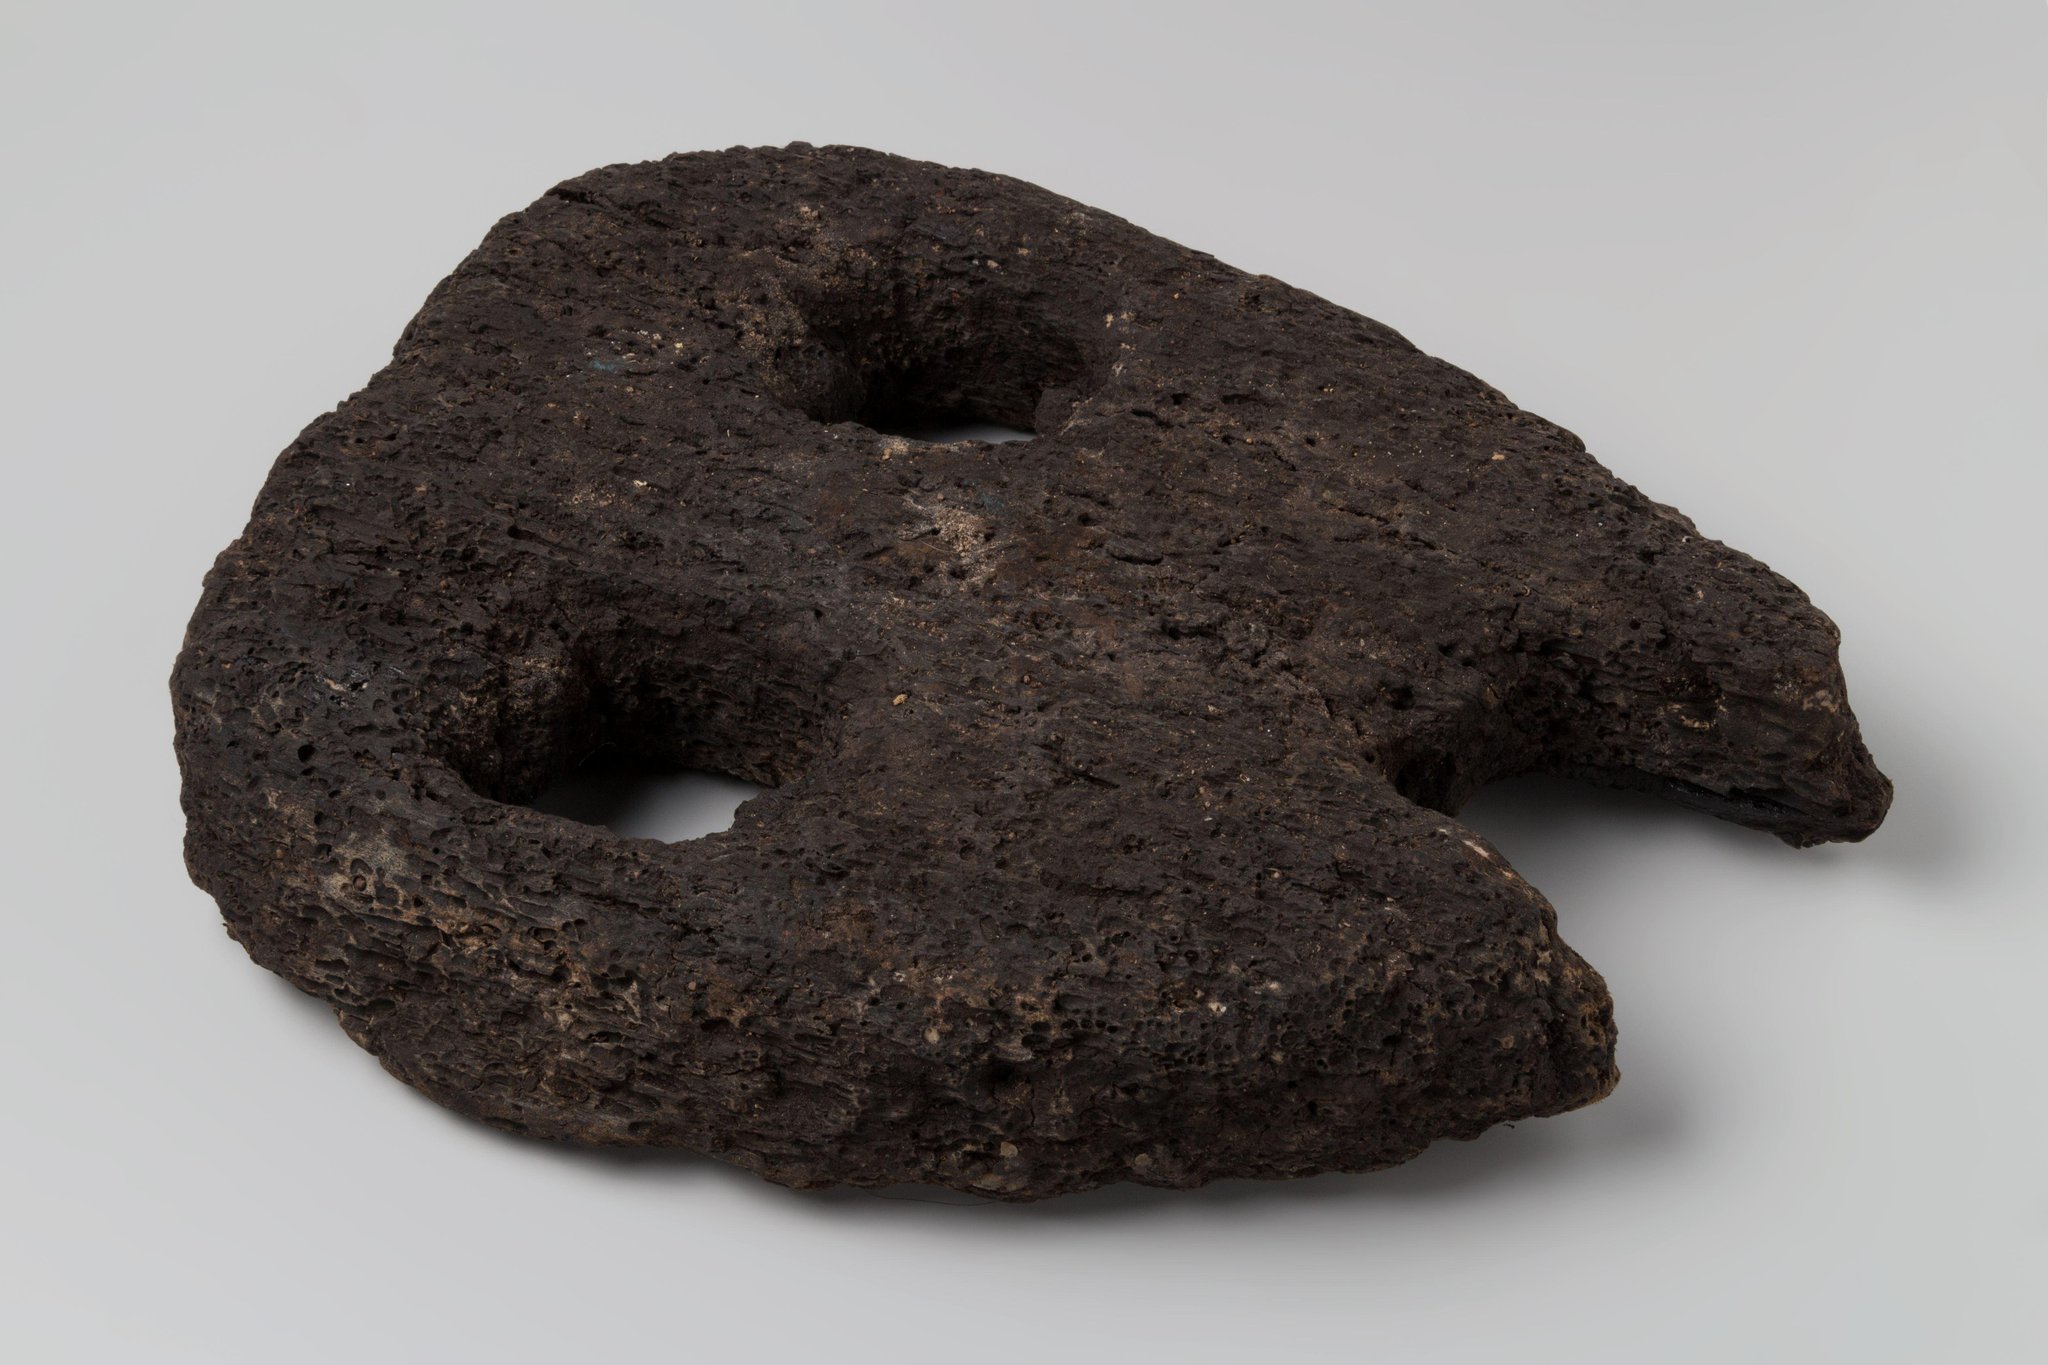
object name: jufferblok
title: Jufferblok uit V.O.C.-schip de 'Witte Leeuw'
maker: Anonymous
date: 1613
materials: wood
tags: verenigde oostindische compagnie, sint-helena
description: Jufferblok uit V.O.C.-schip de 'Witte Leeuw'.